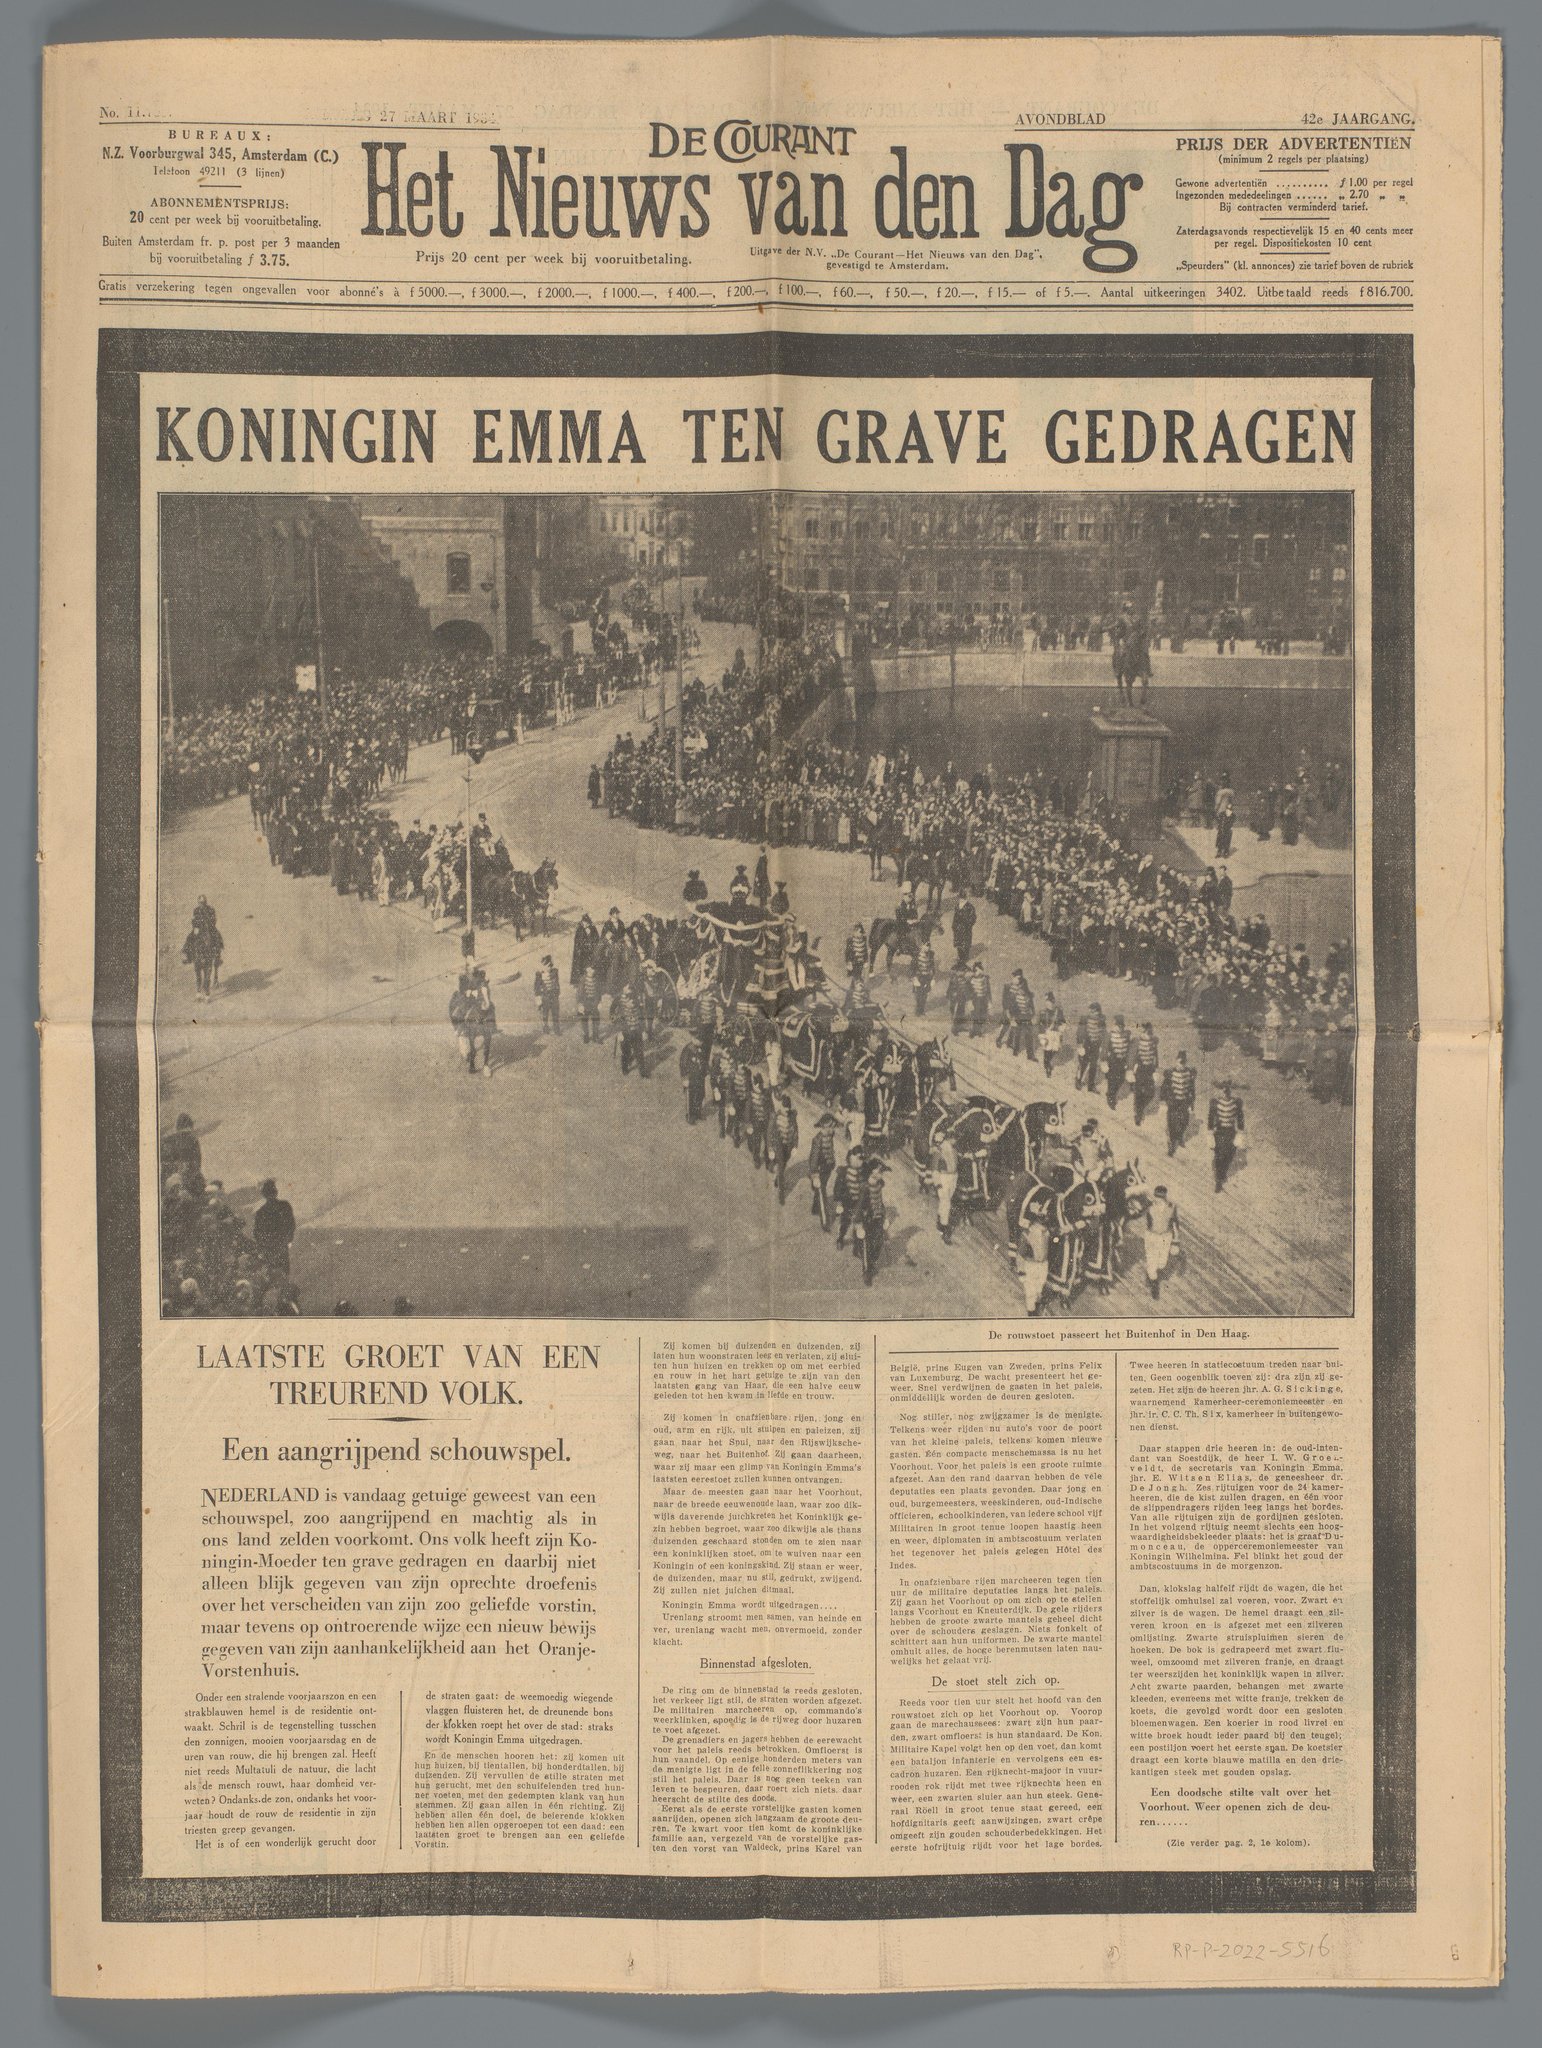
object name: newspaper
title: Het Nieuws van den Dag van 27 maart 1934 met een artikel over de begrafenis van koningin Emma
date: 1934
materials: paper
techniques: letterpress printing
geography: amsterdam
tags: the hague, emma (queen consort of the netherlands), litter, coffin rest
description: Opgevouwen exemplaar van de krant Het Nieuws van den Dag van 27 maart 1934 met een artikel over de begrafenis van koningin Emma op 27 maart. Foto van de begrafenisstoet op het Buitenhof.